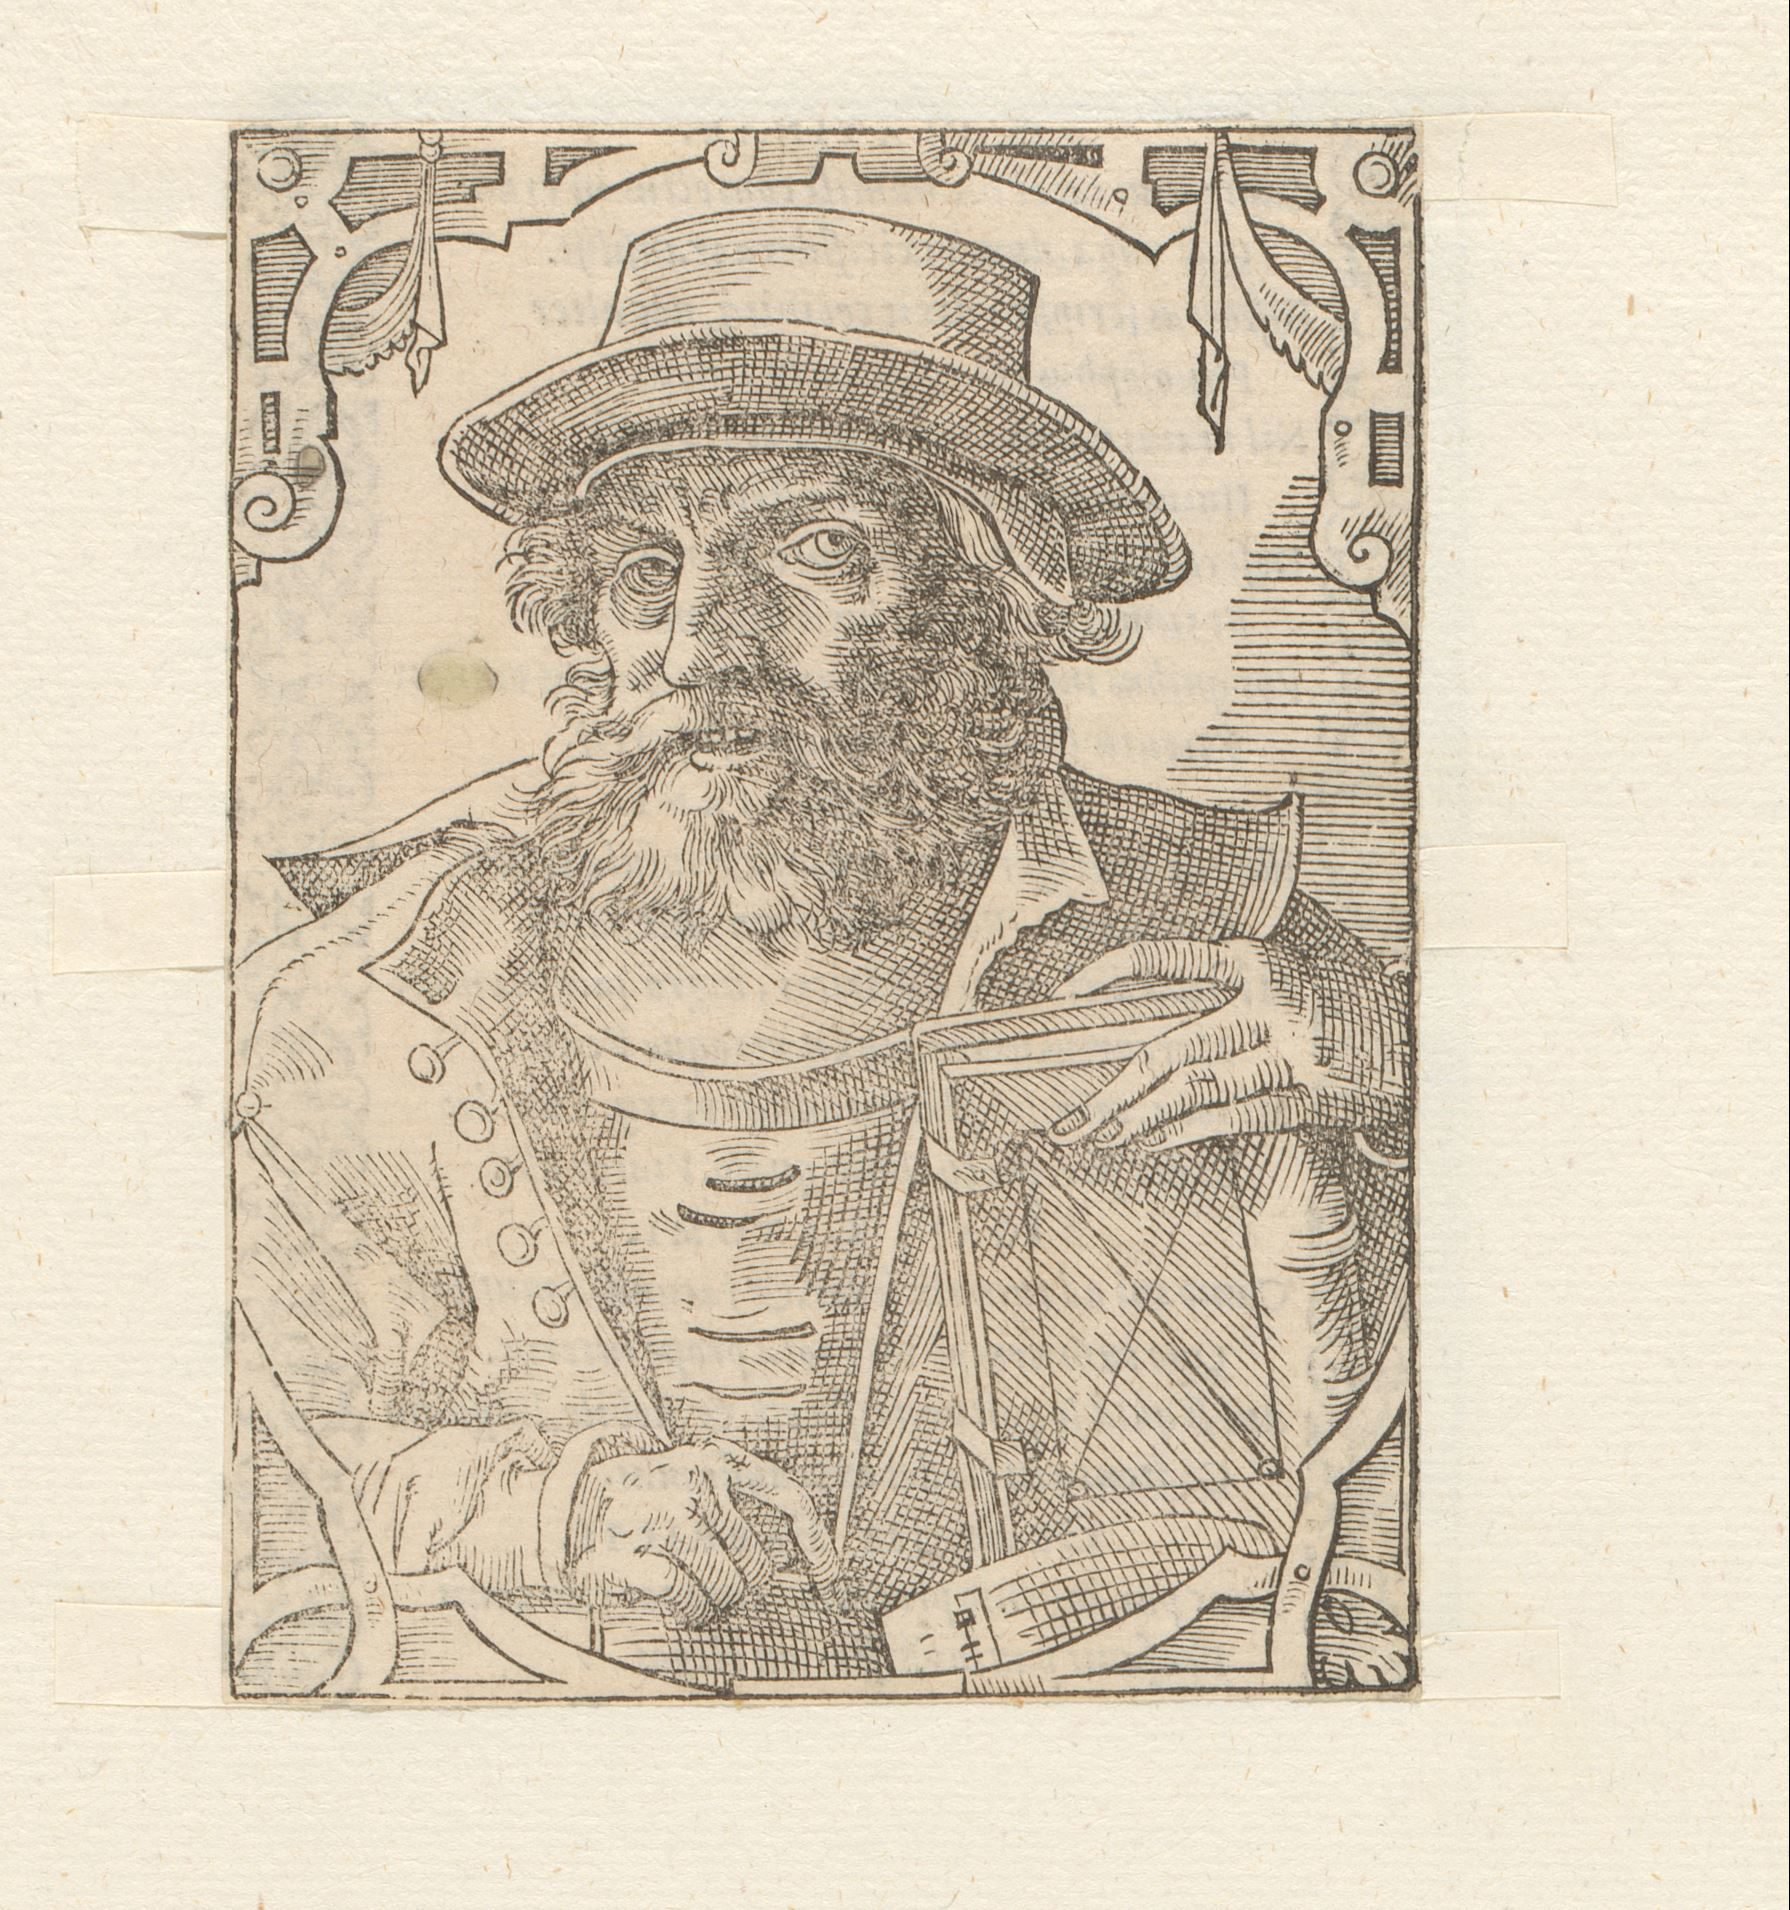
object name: album leaf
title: Portret van Manuel Chrysoloras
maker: Anonymous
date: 1549-1577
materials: paper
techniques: letterpress printing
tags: historical persons, portrait of a writer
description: Prent gebruikt in: Giovio, Paolo. Elogia Virorum literis illustrium (...). Bazel: Peter Perna, 1577.